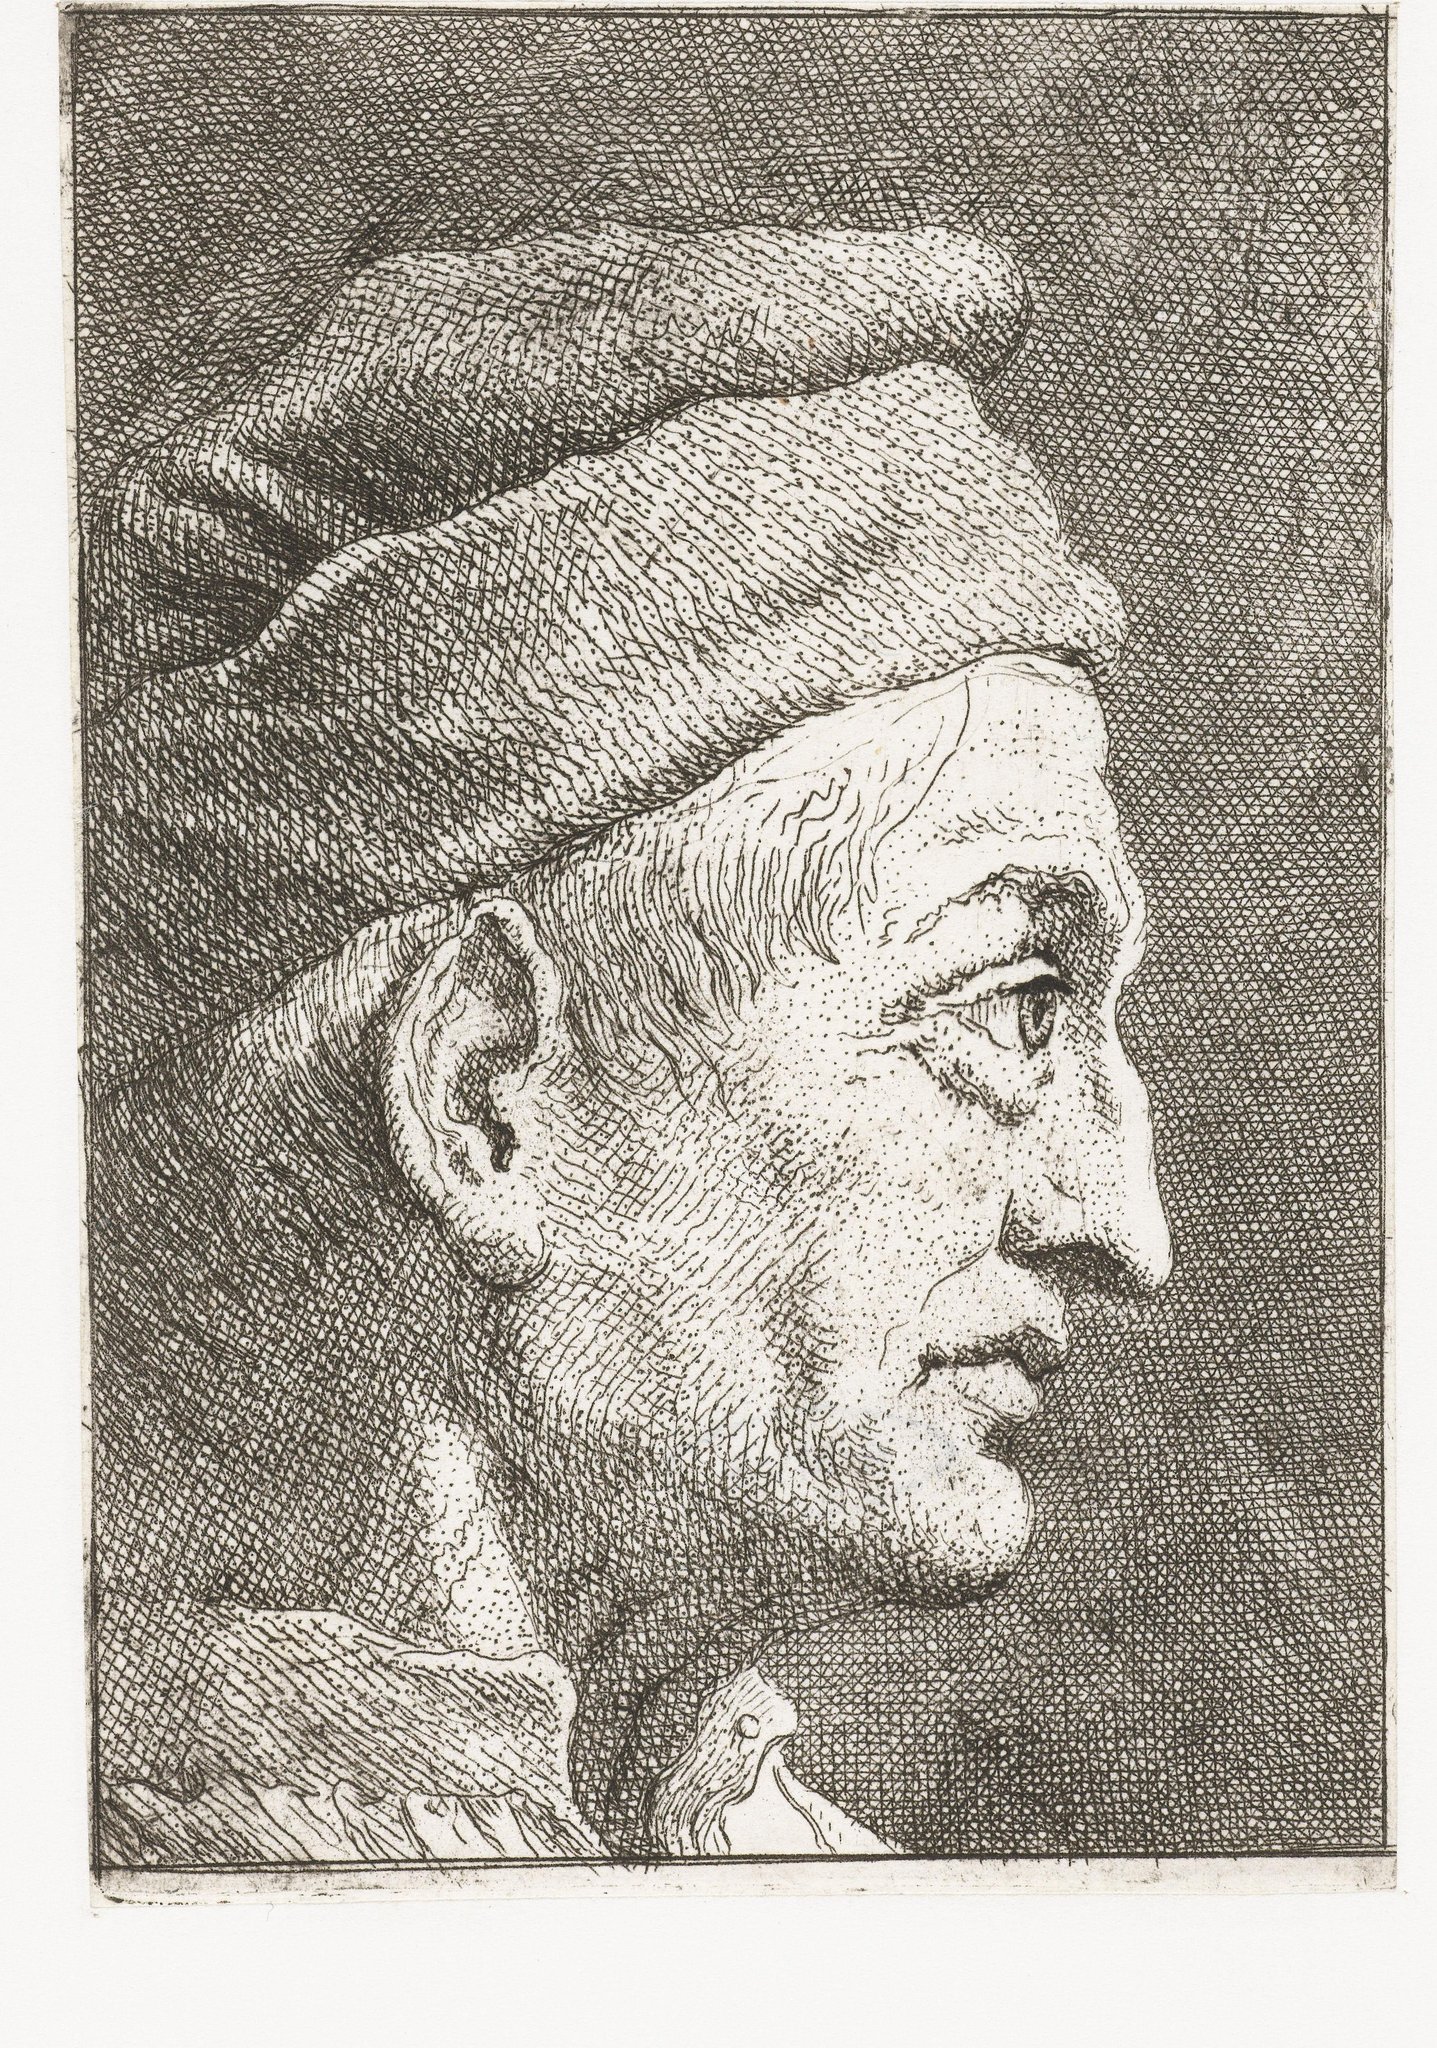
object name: print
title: Verzameling hoofden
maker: giovanni domenico tiepolo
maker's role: draughtsman, print maker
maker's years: 1727-1804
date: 1771-1774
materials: paper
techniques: etching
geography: venice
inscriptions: collector's mark: Lugt 2228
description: Prent uit serie Verzameling hoofden (Raccolta di teste). Giovanni Domenico Tiepolo vervaardigde in de winter van 1757-1758 en in de periode van 1771-1774 deze hoofden naar schilderijen en tekeningen van Giovanni Battista Tiepolo. De eerste uitgave verscheen in 1774 in twee delen met elk dertig prenten. Deze prent werd opgenomen in deel 2.